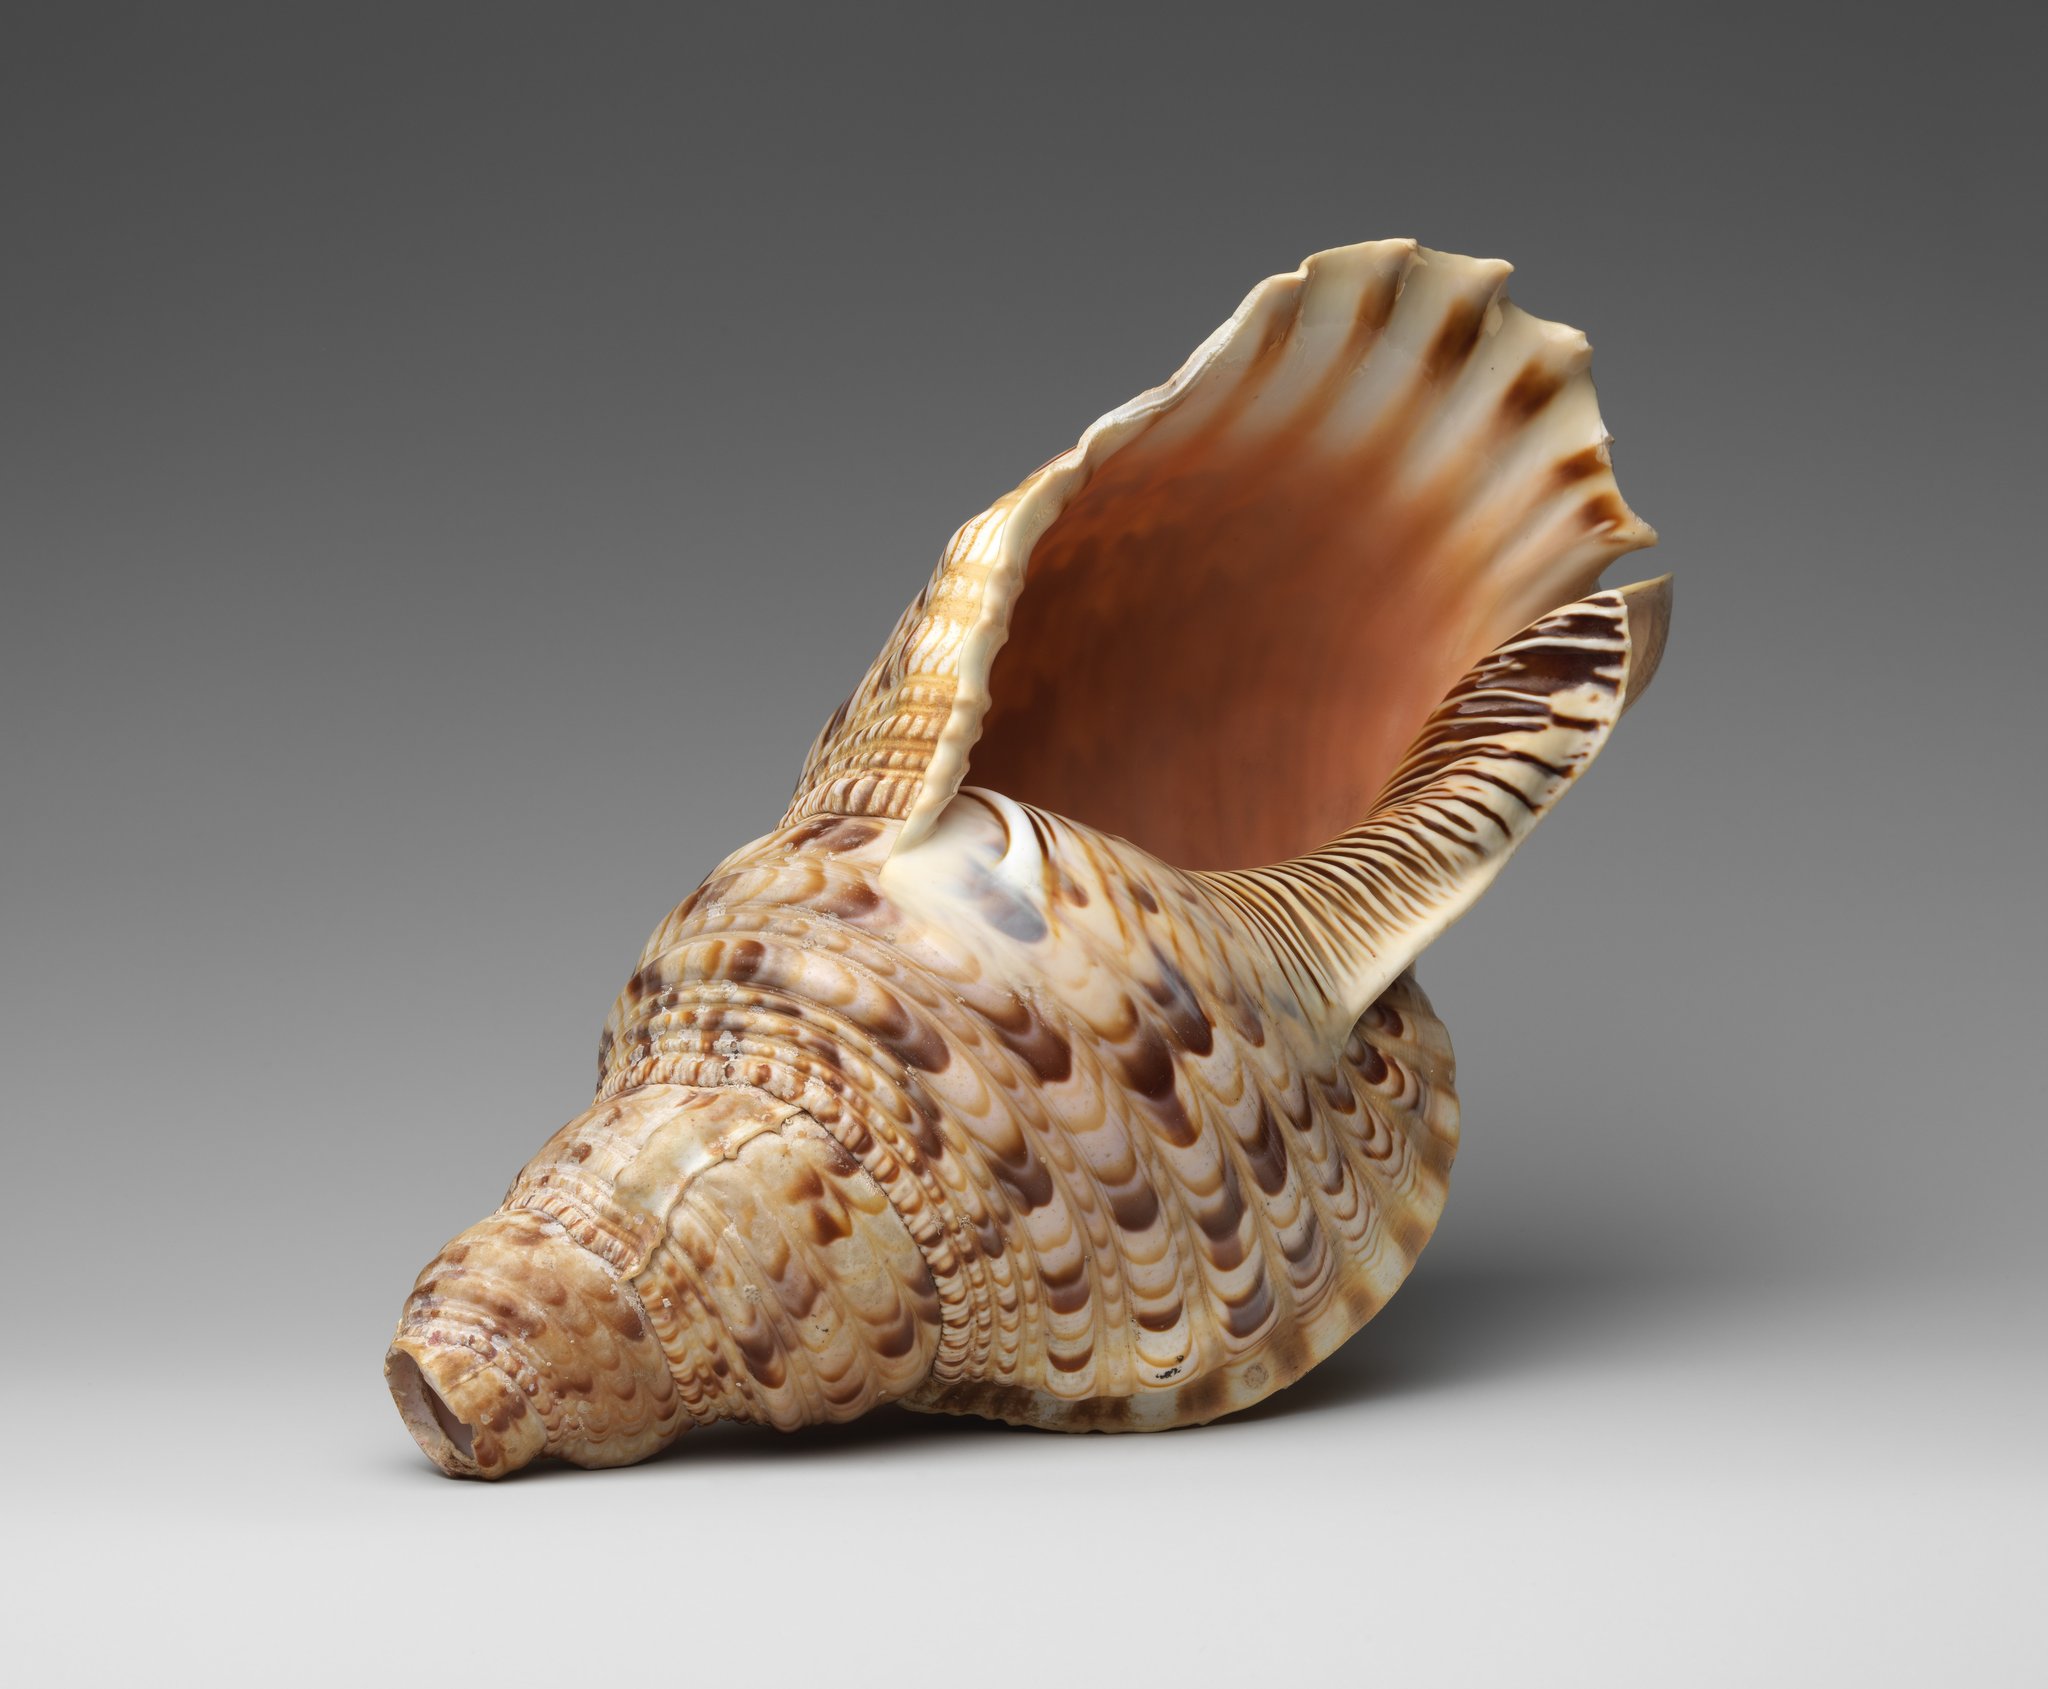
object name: conch shell trumpet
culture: melanesian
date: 1867-1900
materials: shell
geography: vanuatu